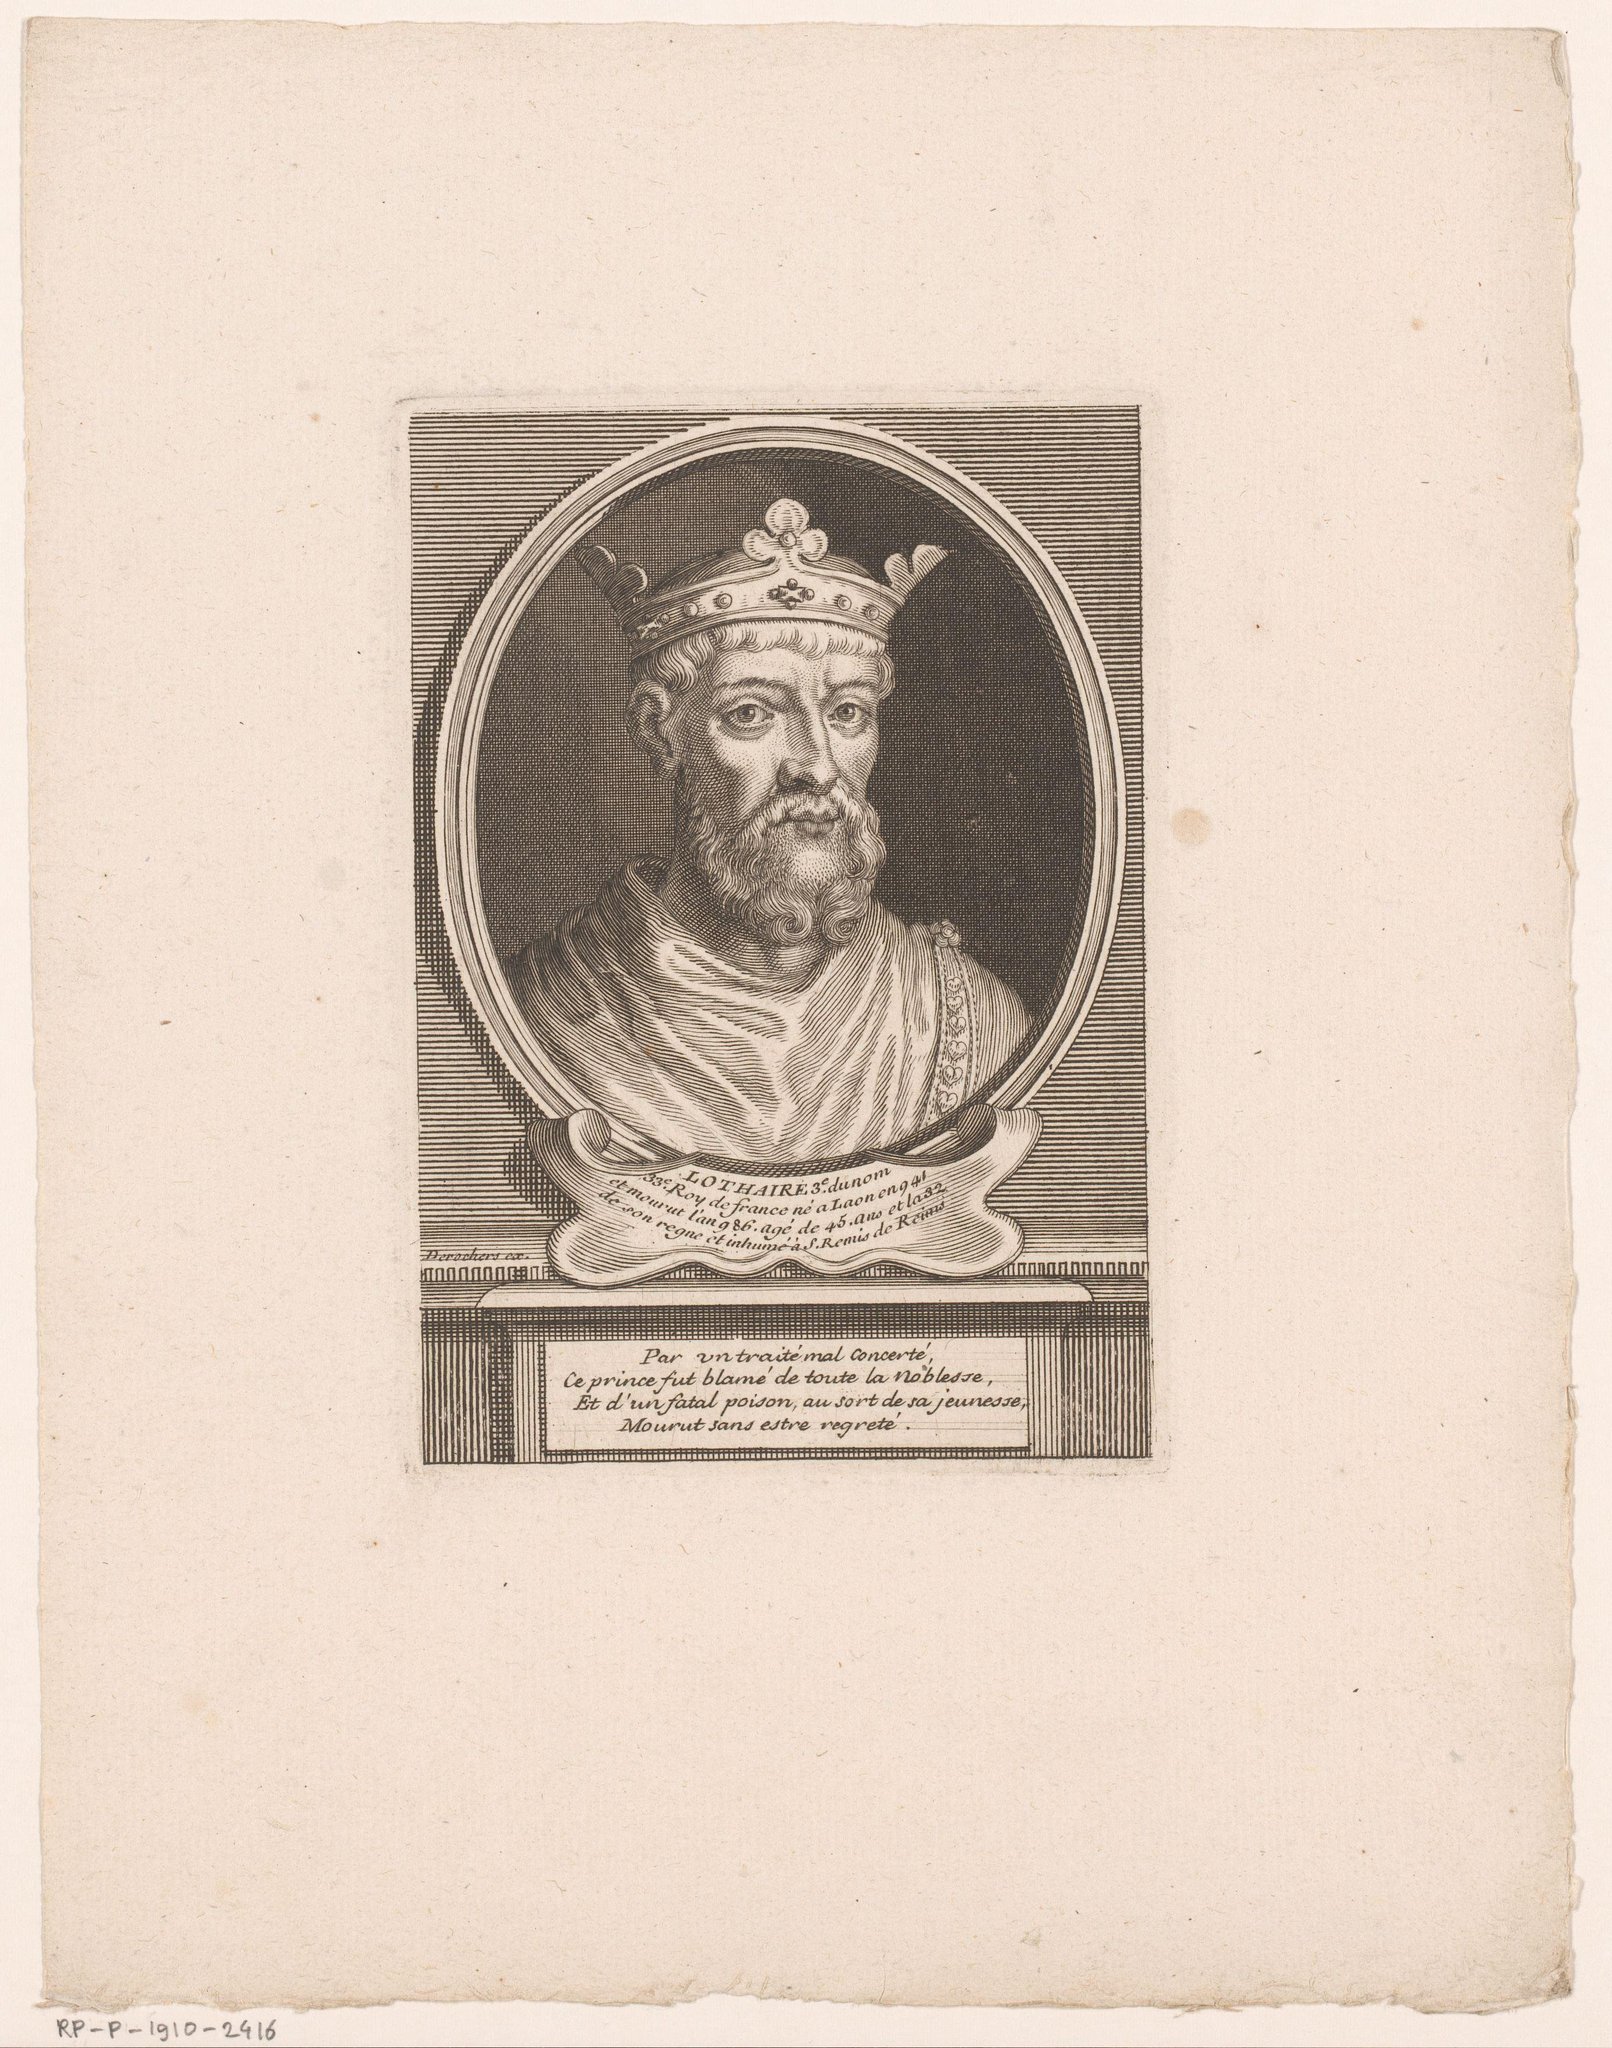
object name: print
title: Recueil de portraits (...)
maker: étienne desrochers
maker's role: print maker, publisher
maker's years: 1668-1741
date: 1726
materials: paper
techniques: engraving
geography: paris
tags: historical persons, king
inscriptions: collector's mark: Lugt 2228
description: Behoort waarschijnlijk tot een serie portretten, grotendeels door Etienne Desrochers, getiteld: 'Recueil de portraits de personnes qui se sont distinguées tant dans les Armes que dans Belles-Lettres et les Arts, comme aussi la famille royale de France et autres cours étrangères'. De serie werd initieel uitgegeven door Desrochers en aangekondigd in 'Mercure' in mei 1726, p. 985. Echter was Desrochers reeds enkele jaren eerder begonnen met het uitgeven van de serie. Na de dood van Desrochers werd de serie voortgezet door Gilles Edme Petit. Een latere staat werd uitgegeven door Jean François Daumont in Parijs.